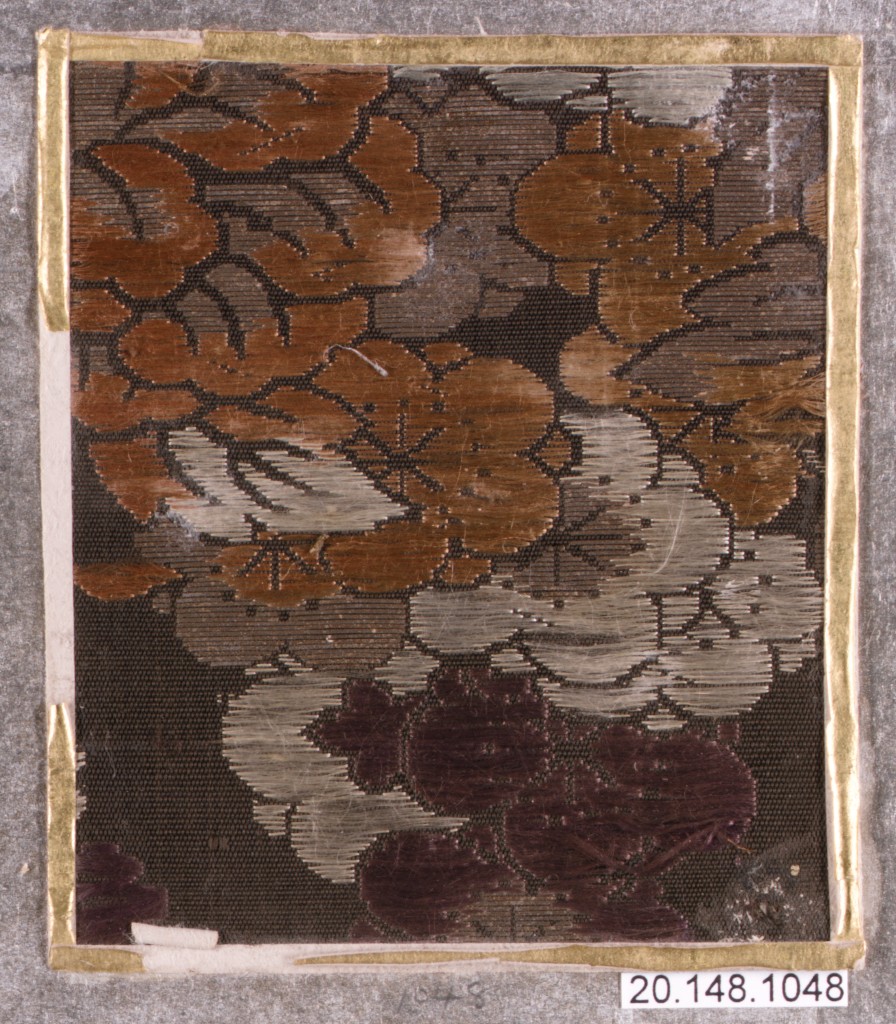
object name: piece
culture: japanese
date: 1701-1800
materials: silk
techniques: compound weave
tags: flowers